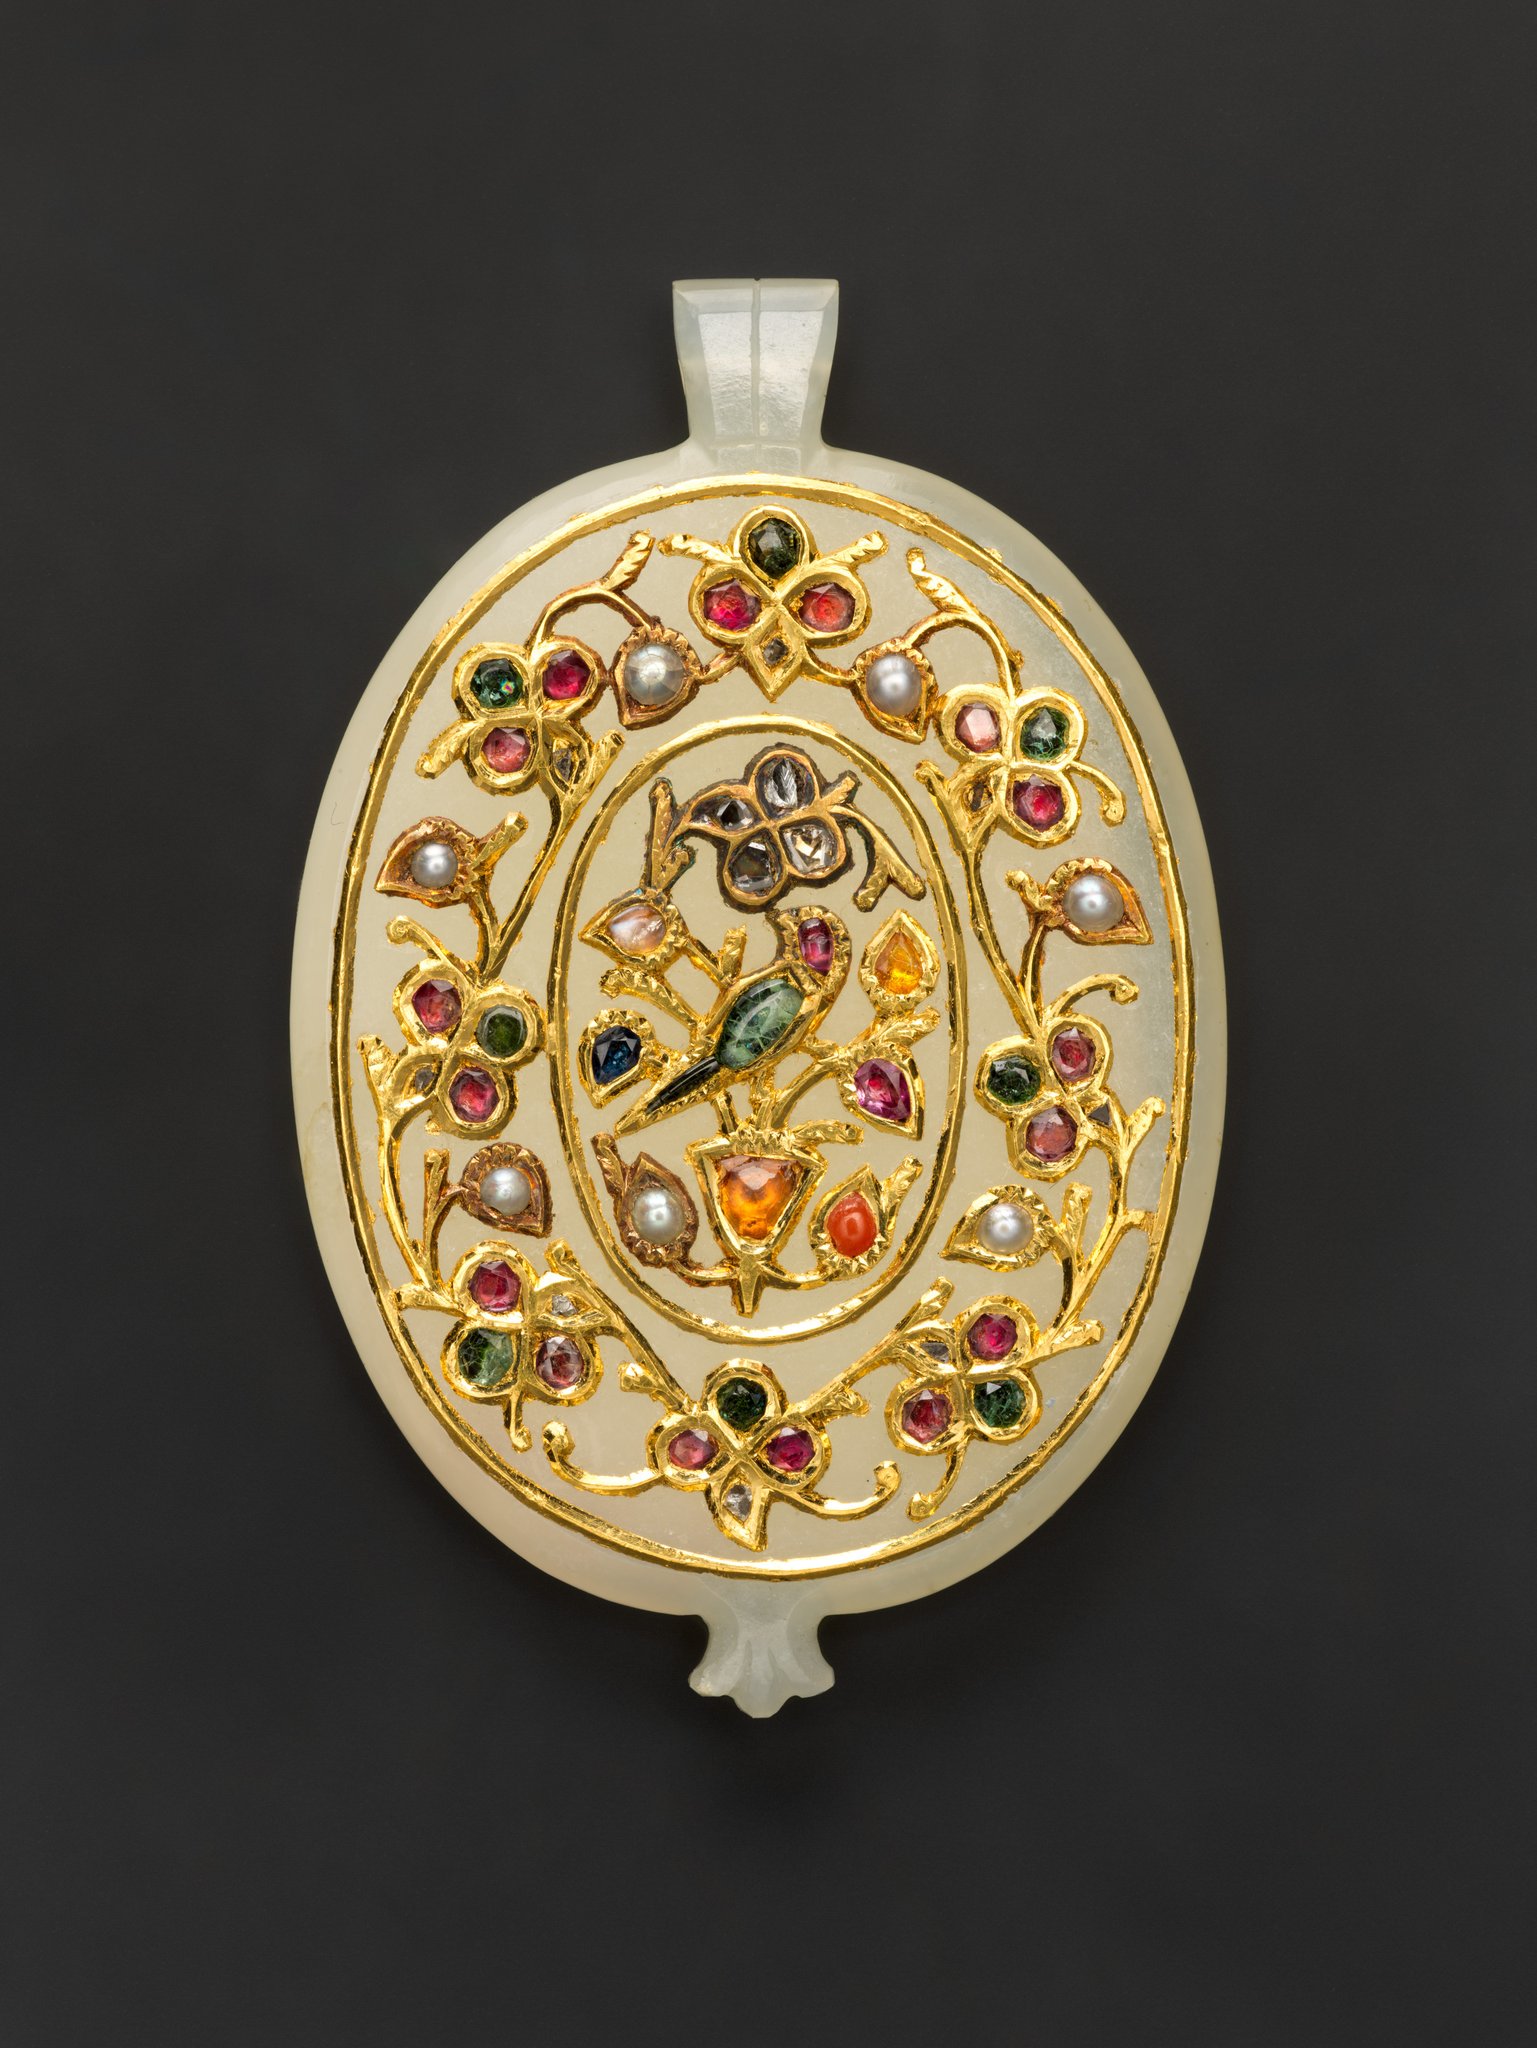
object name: pendant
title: Jewelled Pendant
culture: indian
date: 1801-1900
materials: coral, jade, pearl